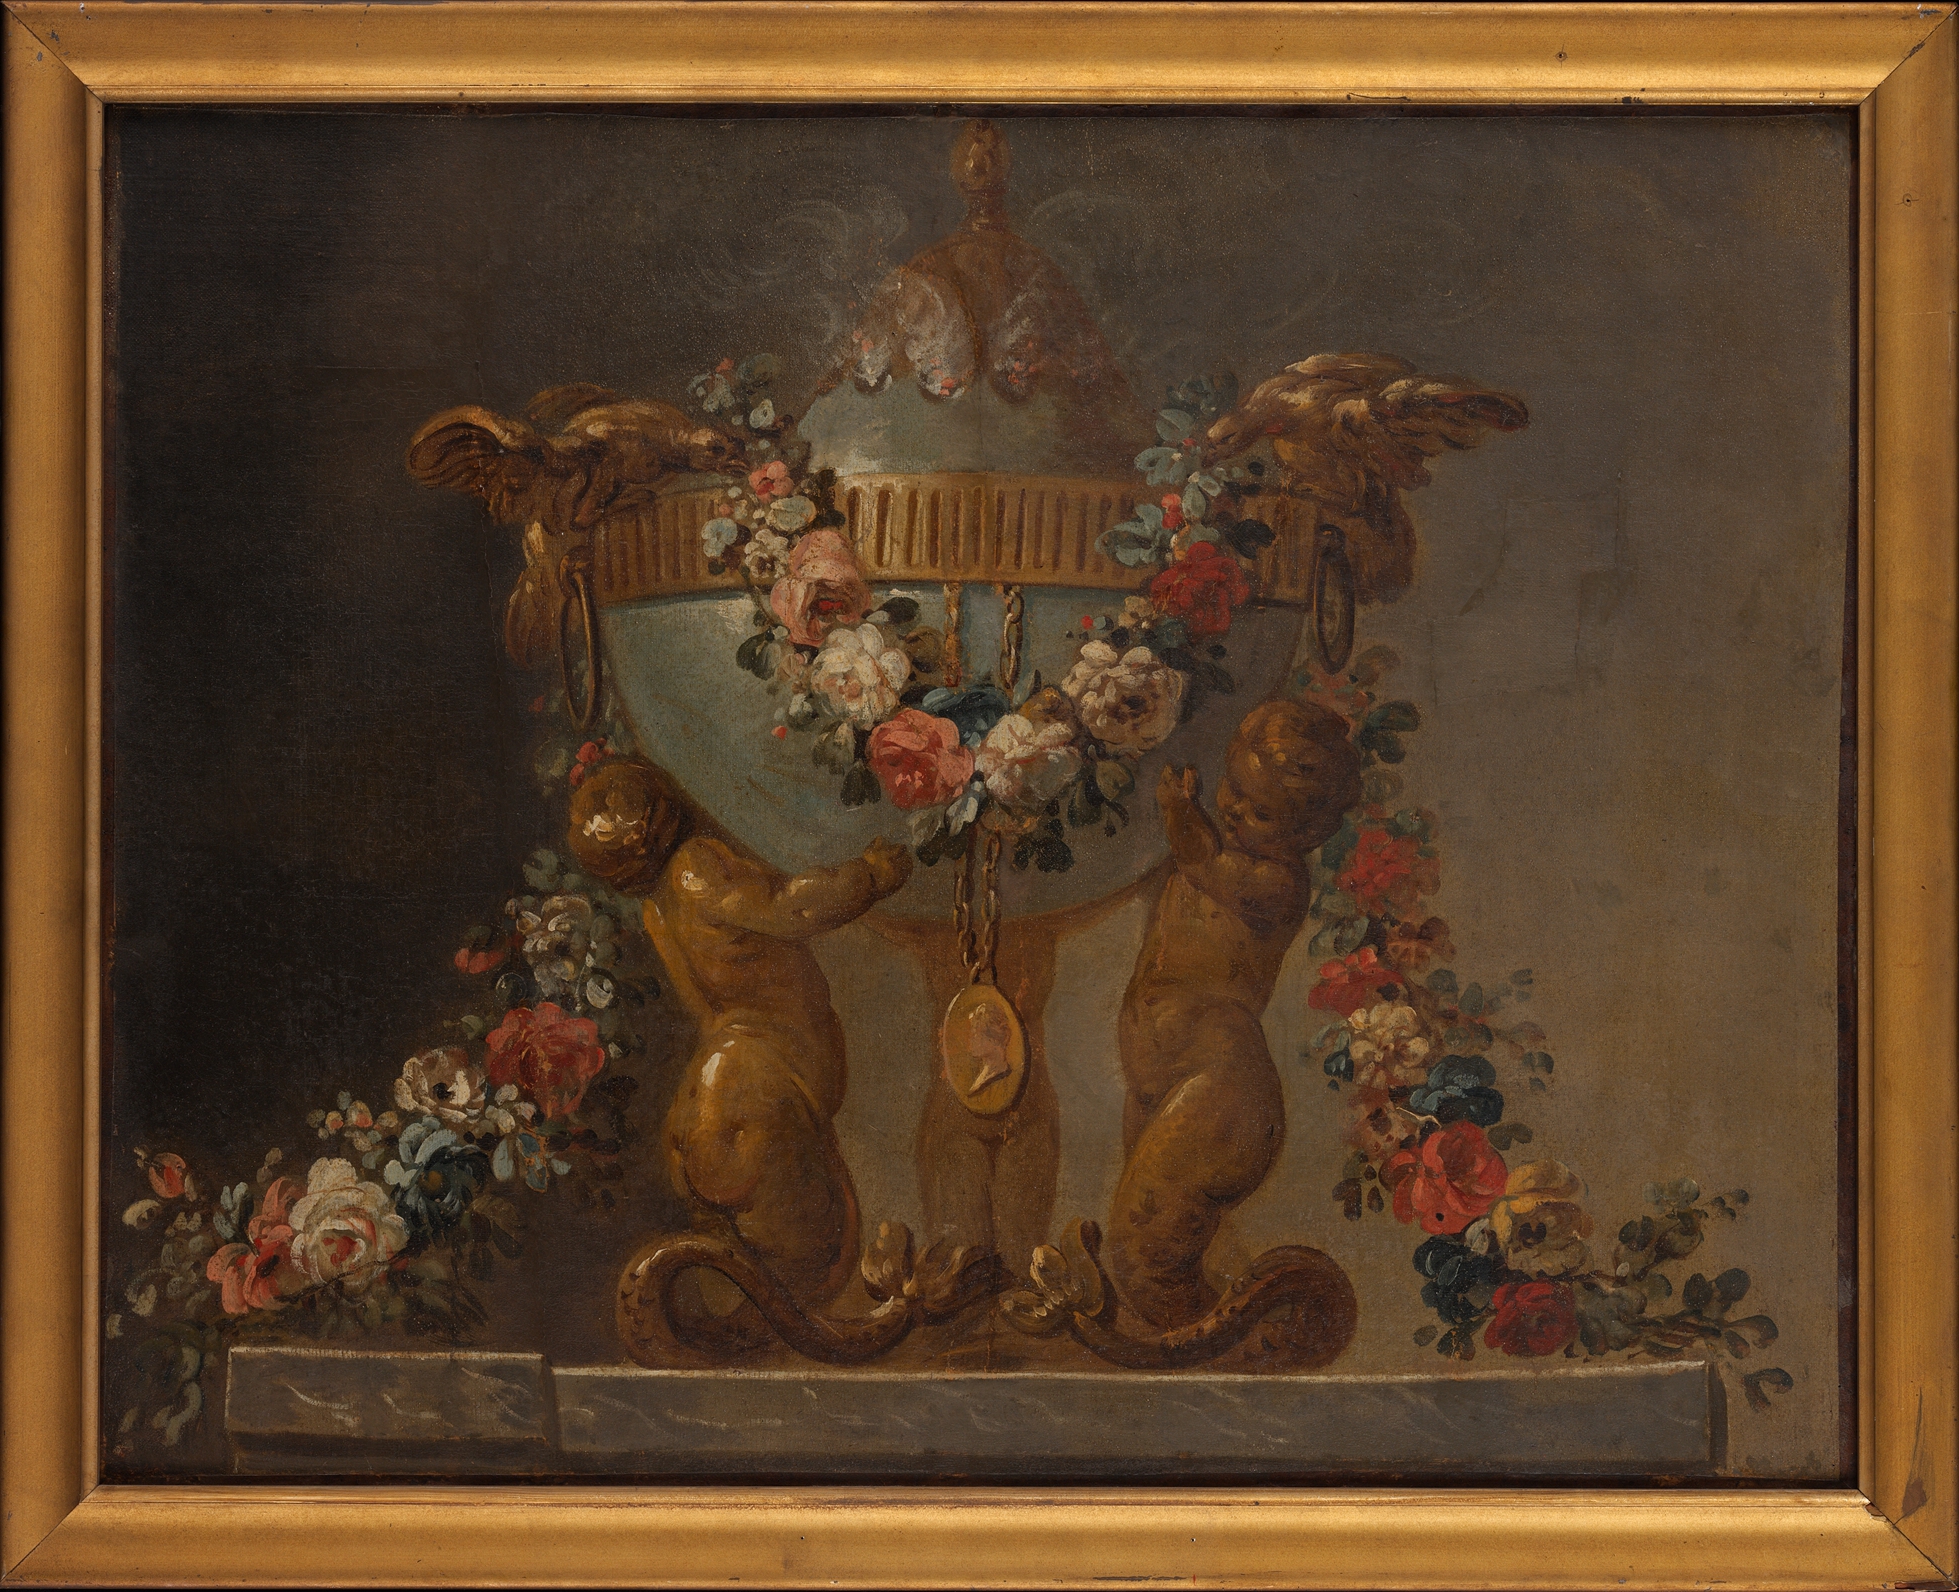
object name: overdoor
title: Perfume-burner supported by baby tritons and garlanded with flowers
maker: french painter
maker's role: artist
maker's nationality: french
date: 1701-1800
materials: canvas, oil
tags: garlands,triton